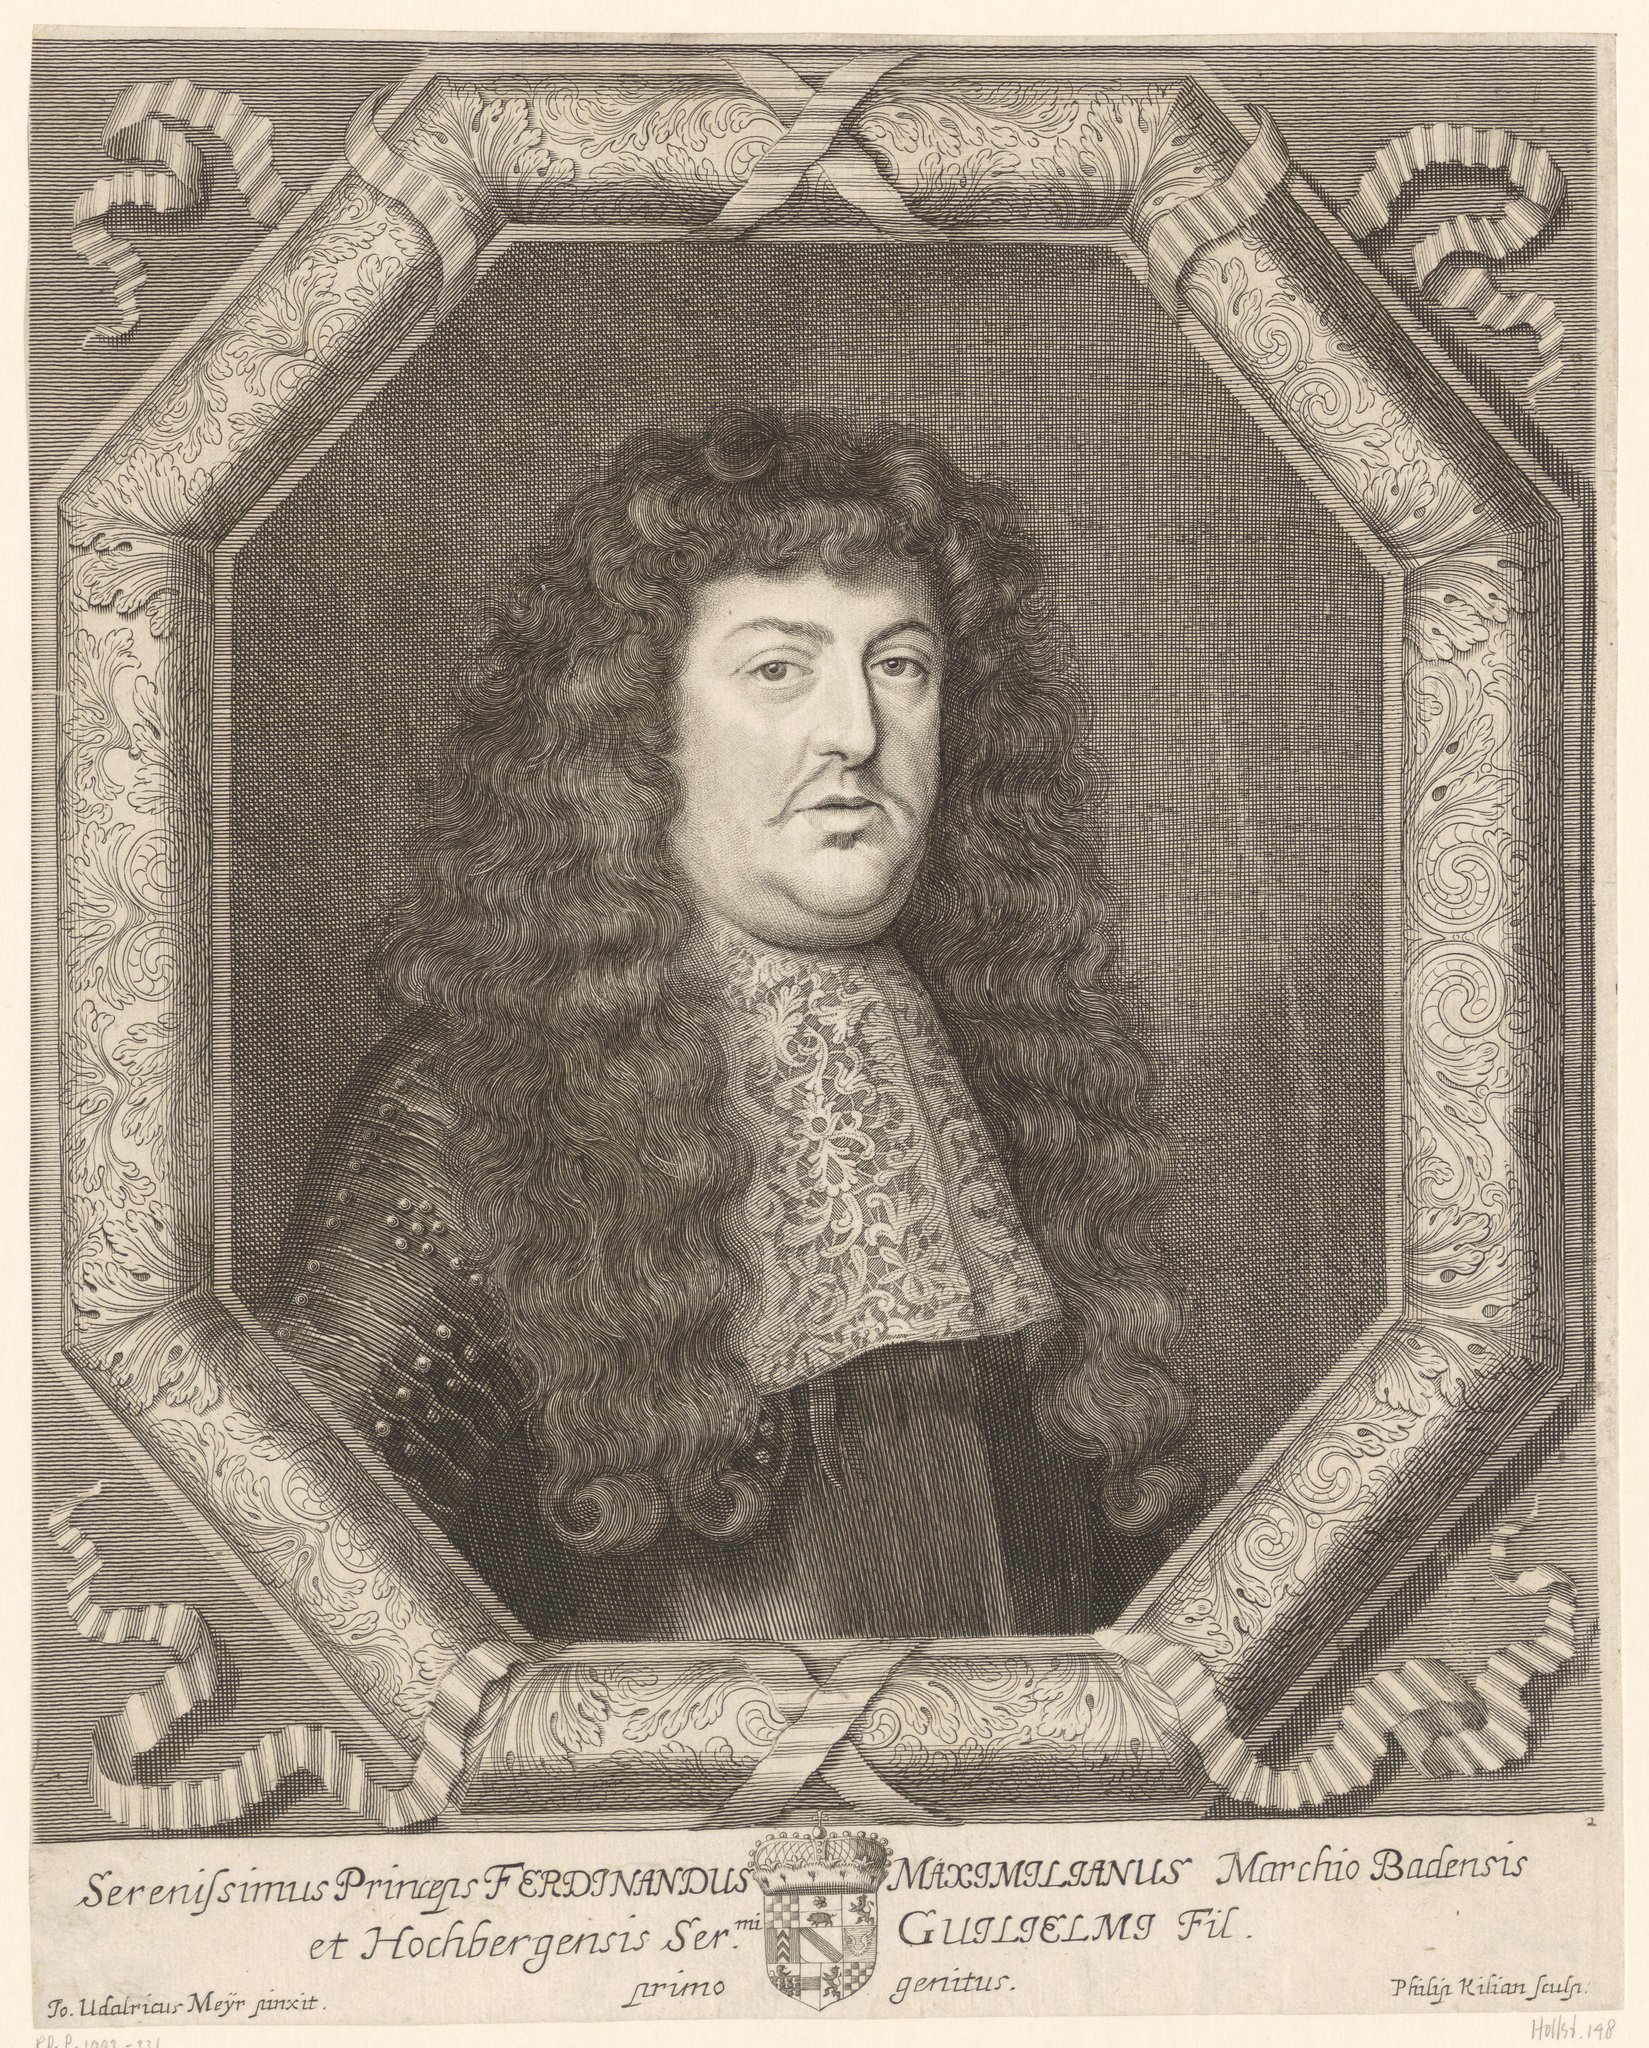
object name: print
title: Portret van Ferdinand Maximiliaan van Baden-Baden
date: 1638-1693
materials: paper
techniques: engraving, etching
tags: historical persons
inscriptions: collector's mark: Lugt 1644, collector's mark: Lugt 2228